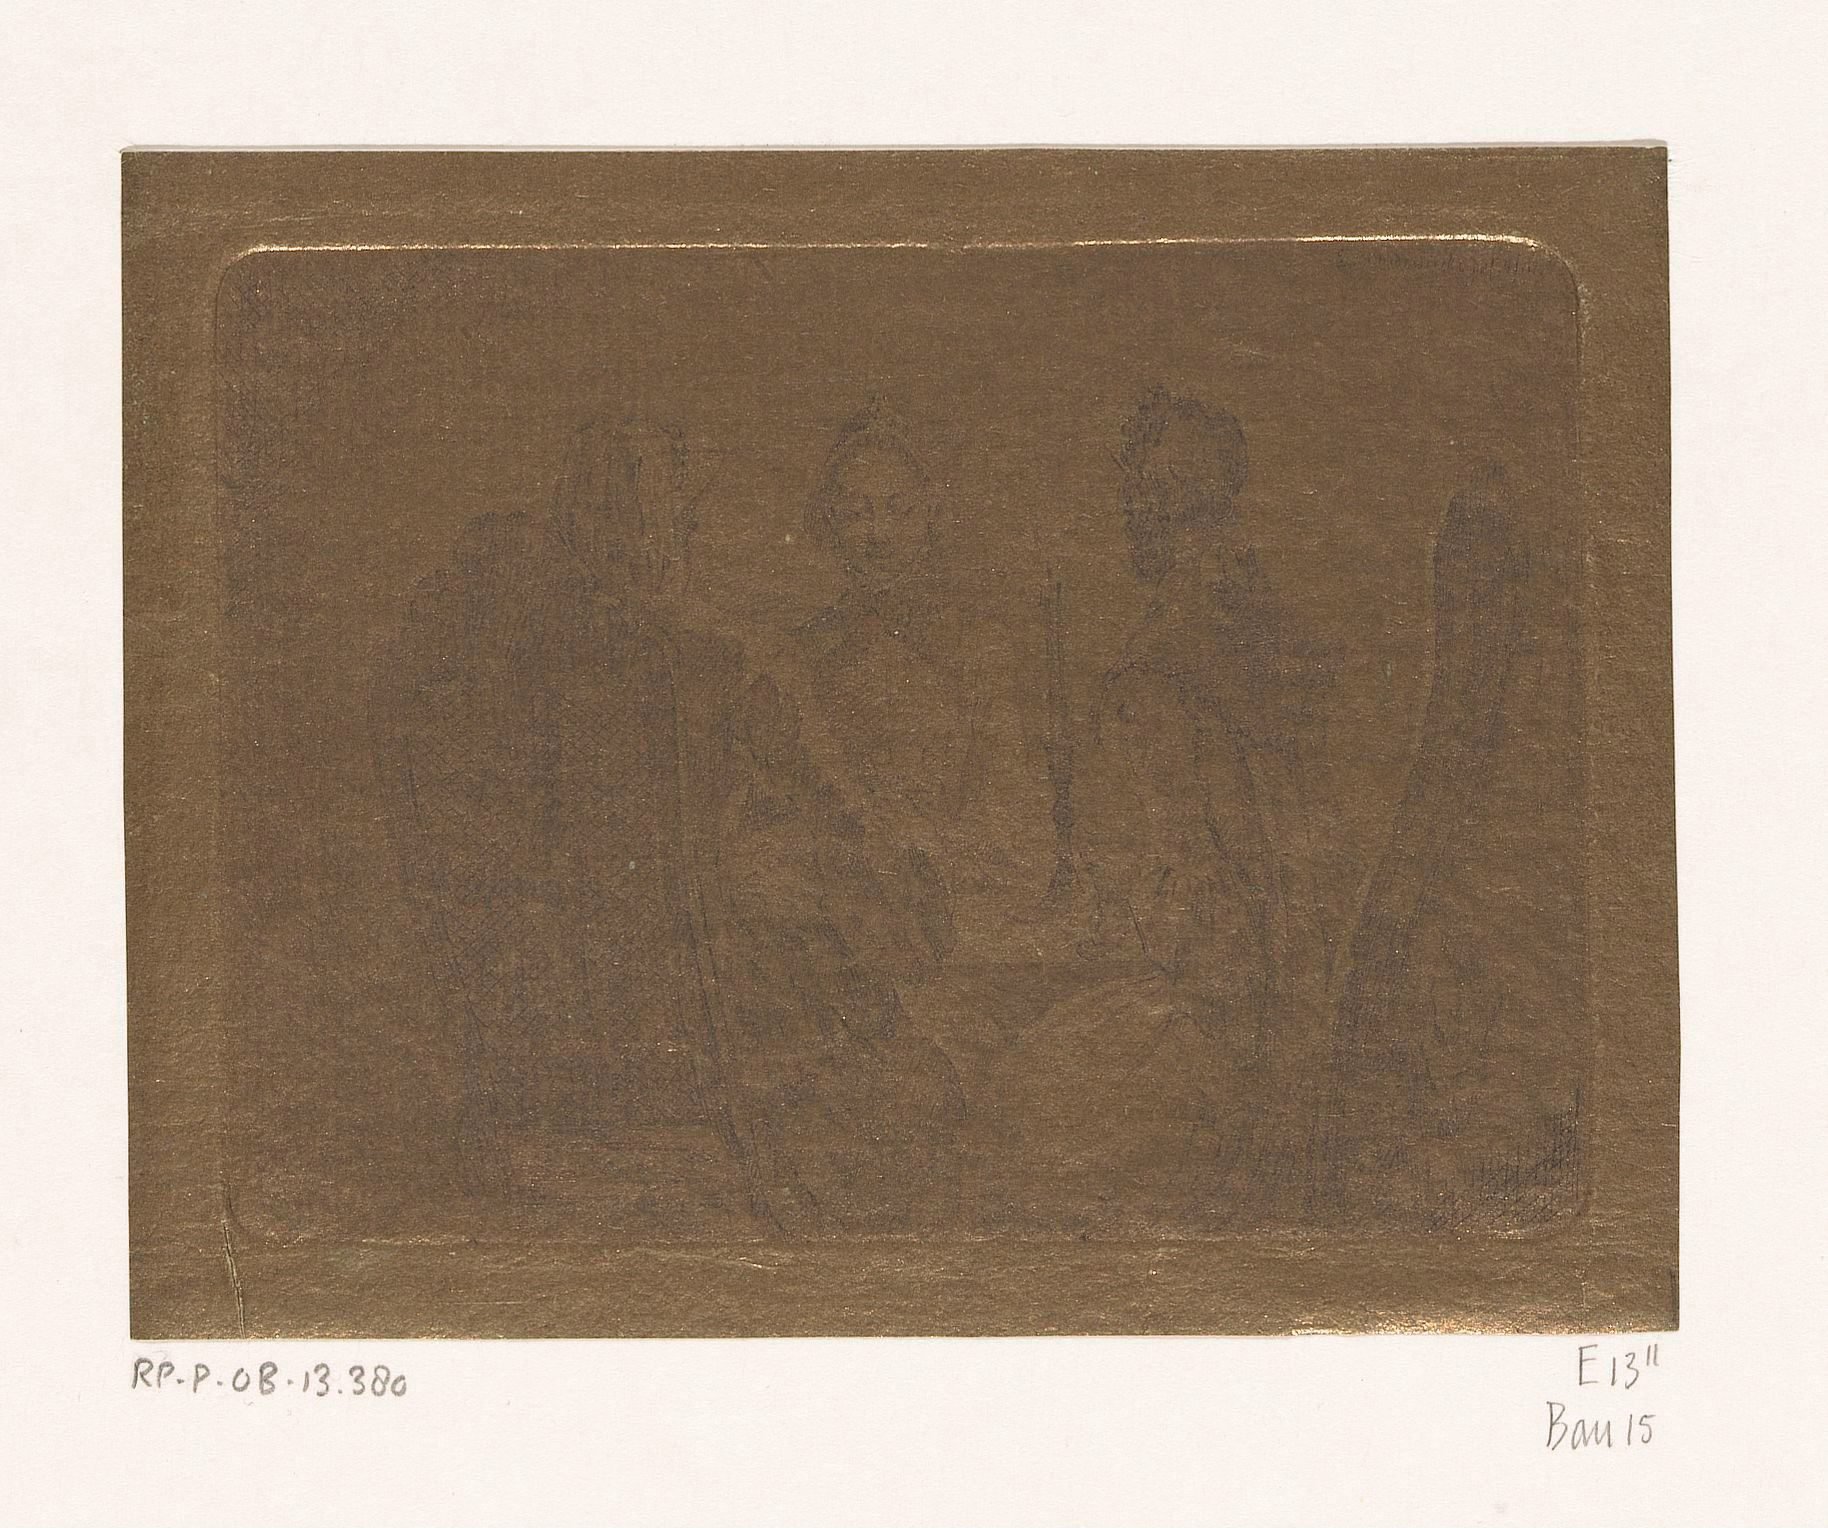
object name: print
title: Drie kaartspelende dames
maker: daniel nikolaus chodowiecki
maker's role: draughtsman, print maker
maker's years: 1726-1801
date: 1758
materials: paper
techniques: aquatint, etching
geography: berlin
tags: historical persons - bb - woman, card games, candlestick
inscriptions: collector's mark: Lugt 2228